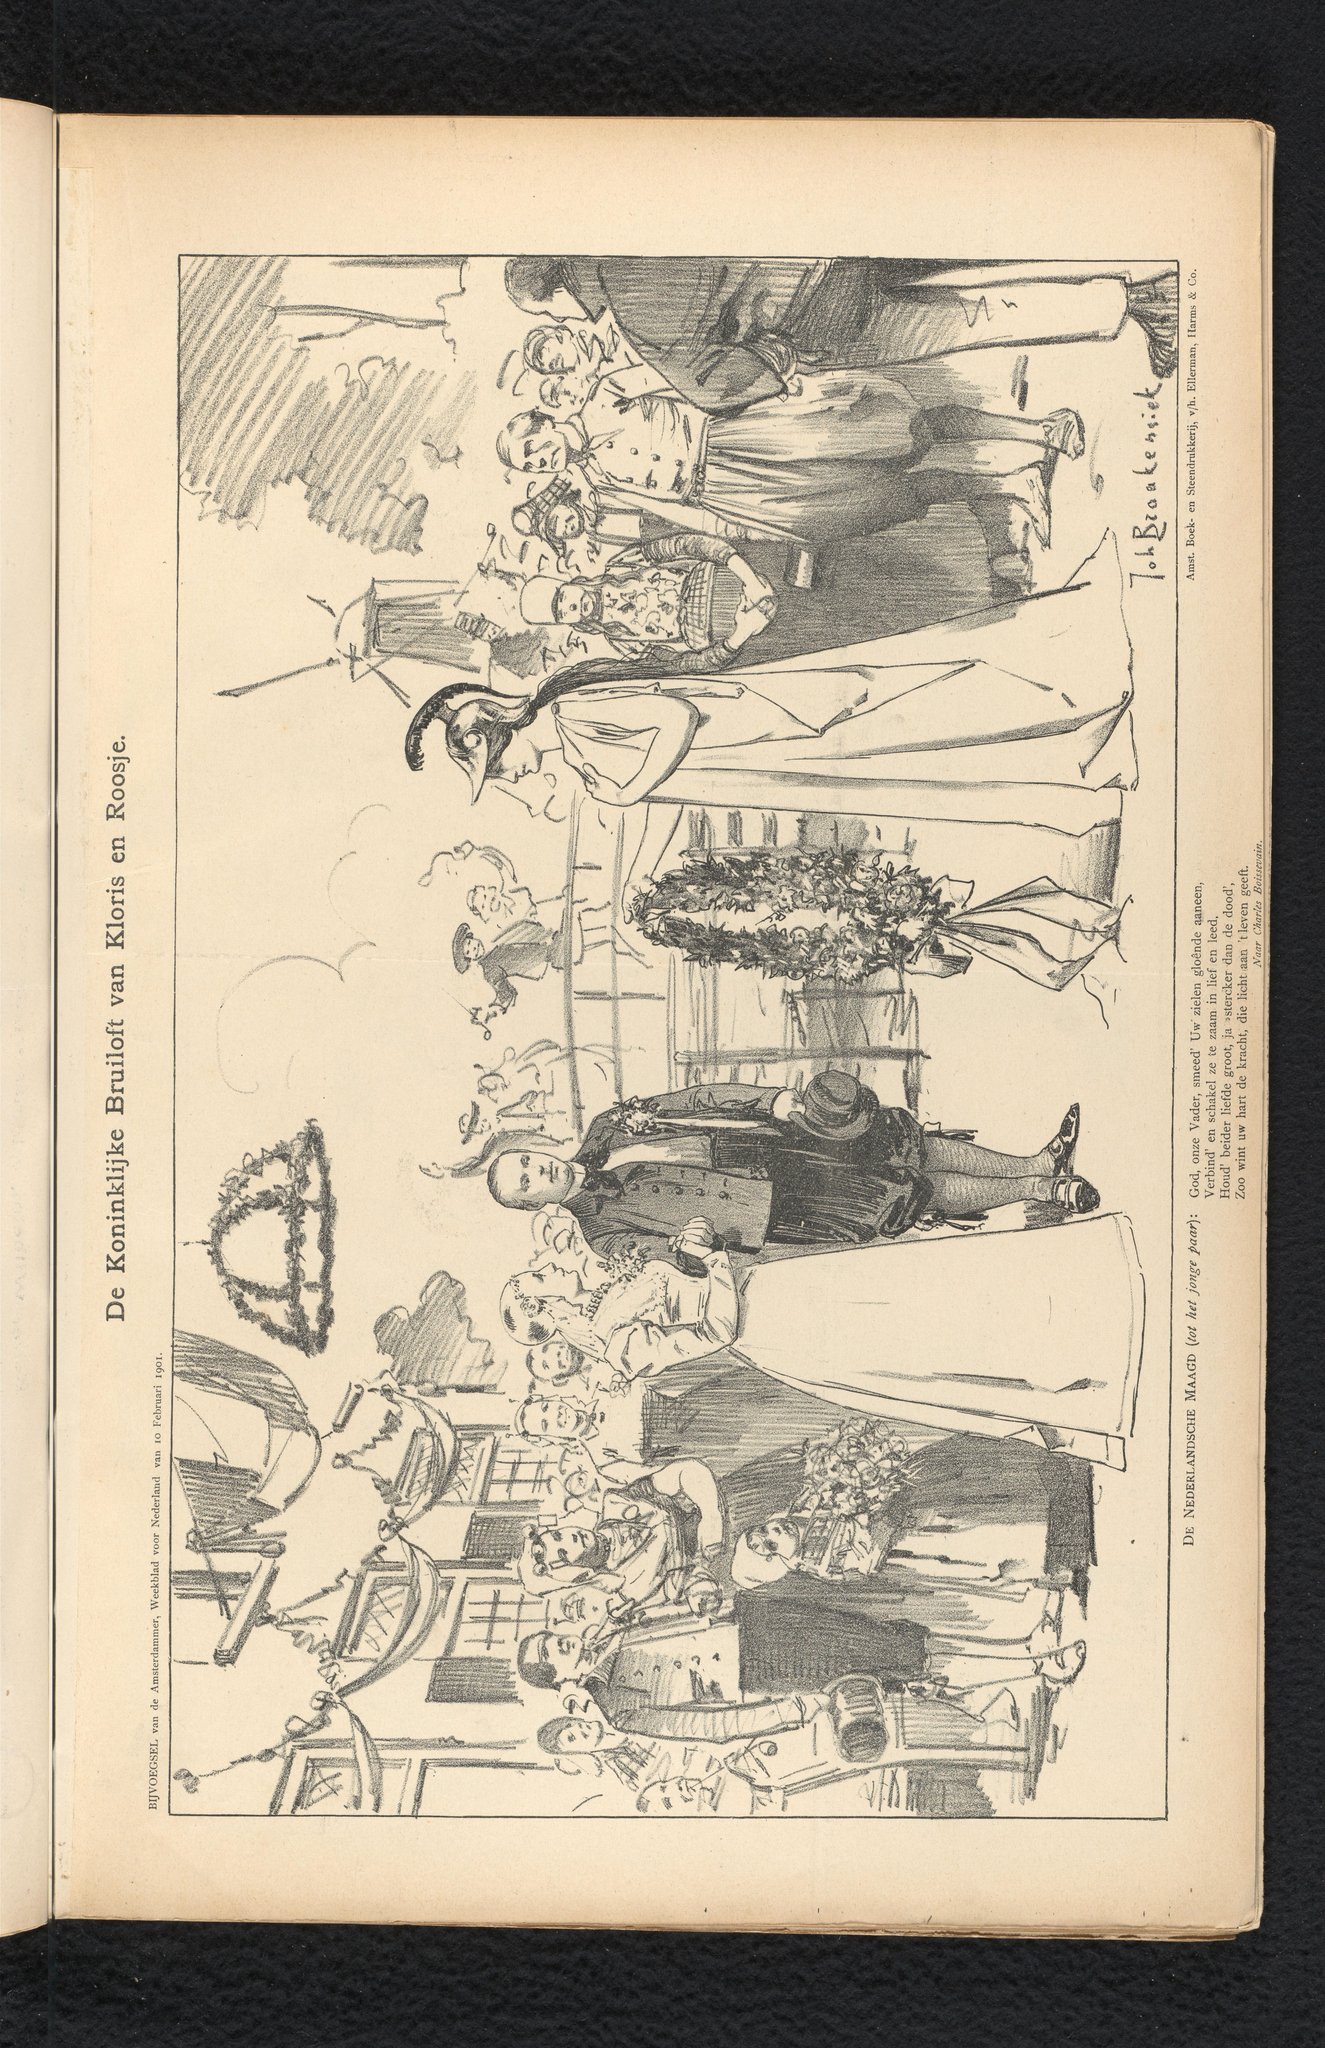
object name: cartoon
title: De Koninklijke Bruiloft van Kloris en Roosje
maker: johan braakensiek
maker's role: draughtsman, print maker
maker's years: 1858-1940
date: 1901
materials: paper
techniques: lithograph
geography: netherlands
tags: the hague, print maker, wilhelmina of the netherlands, hendrik (prins der nederlanden (1876-1934)), civil marriage ceremony, personifications of countries, nations, states, districts, etc., wedding feast, wedding meal, political caricatures and satires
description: Het huwelijk van koningin Wilhelmina en prins Hendrik op 7 februari 1901 voorgesteld als de bruiloft van Kloris en Roosje, naar de gelijknamige klucht. De Nederlandse Maagd met krans spreekt het bruidspaar toe.